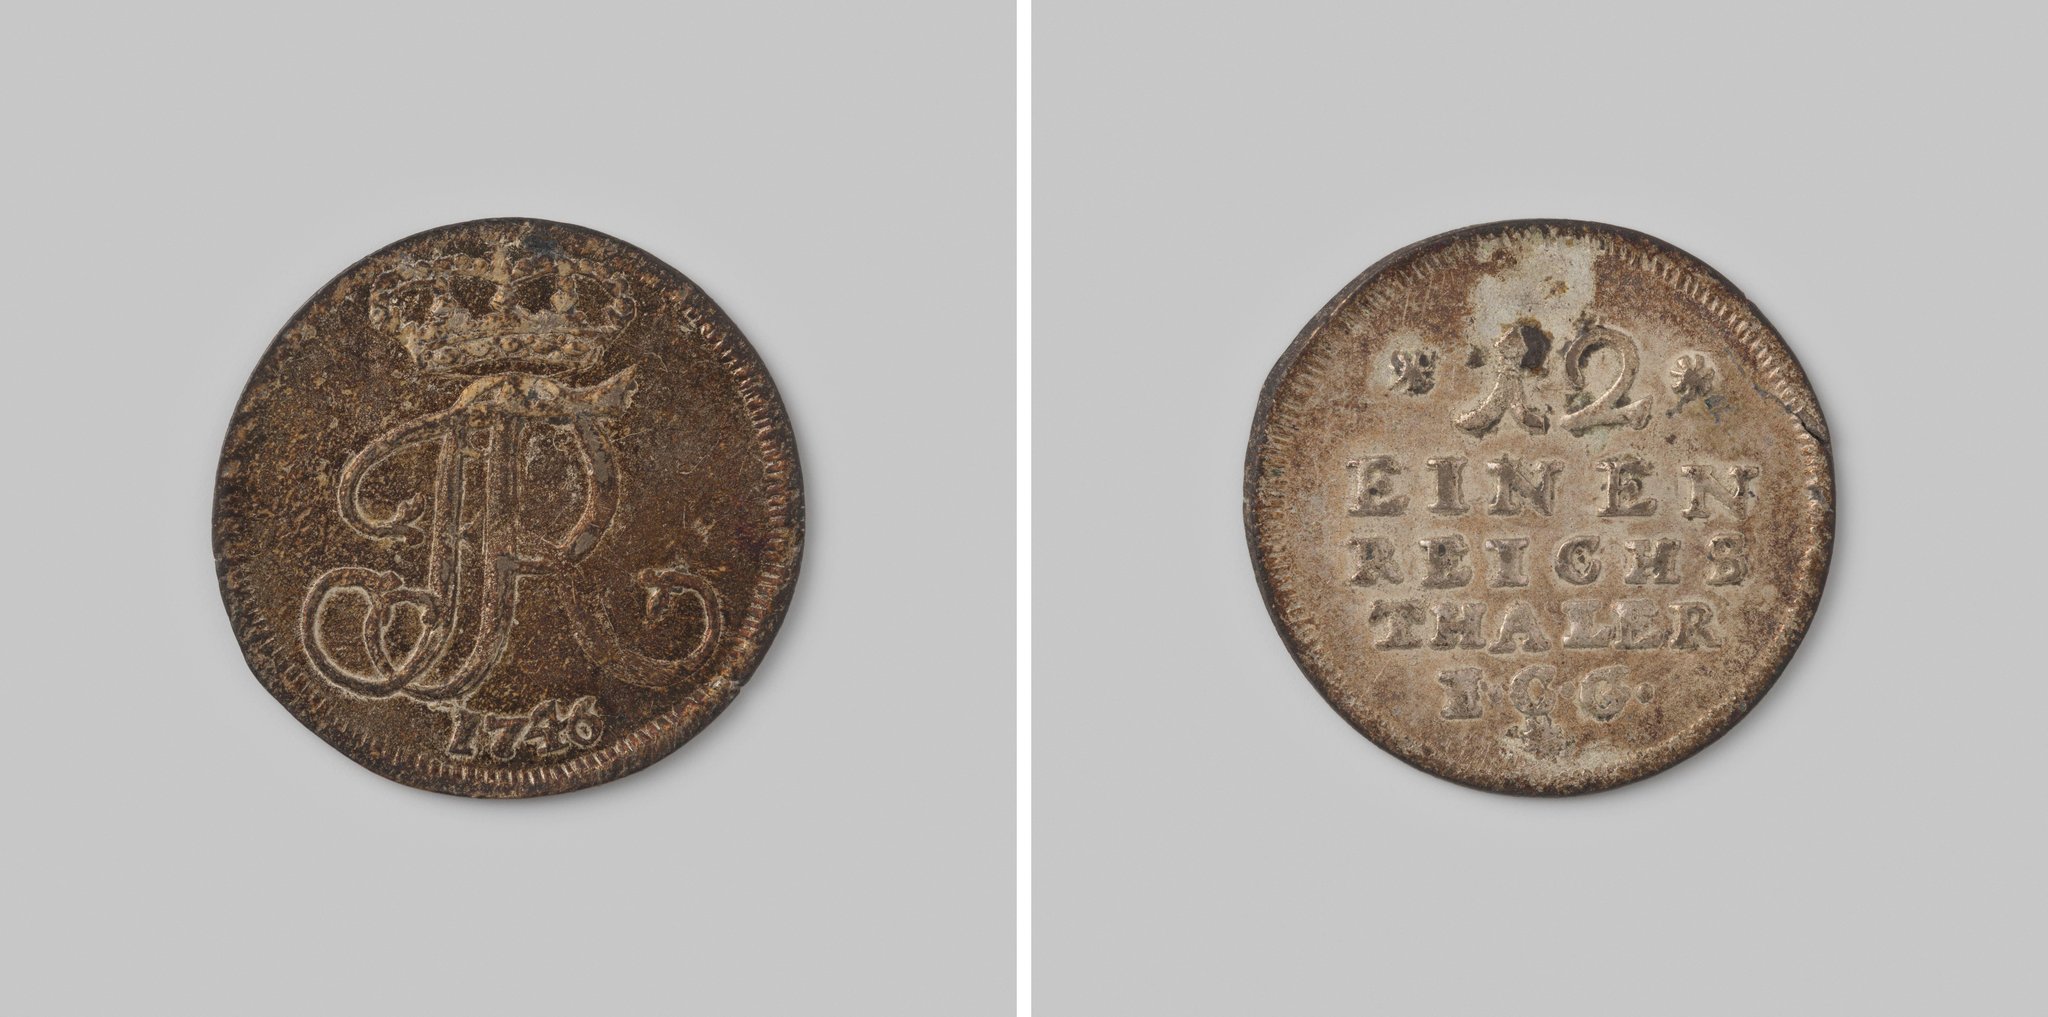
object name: coin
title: Graafschap Oost-Friesland, Friedrich II van Pruisen, 2 Mariëngroschen, 1746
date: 1746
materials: silver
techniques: striking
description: Koper-zilveren munt. Voorzijde: gekroond monogram van de vorst, waaronder jaartal. Keerzijde: waarde-aanduiding in vier regels. Gladde rand.